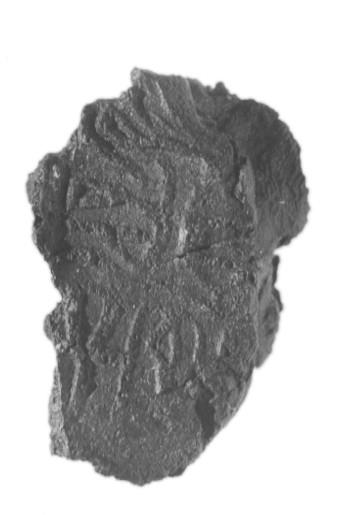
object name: sealing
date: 2030-1640 BCE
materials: clay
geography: egypt